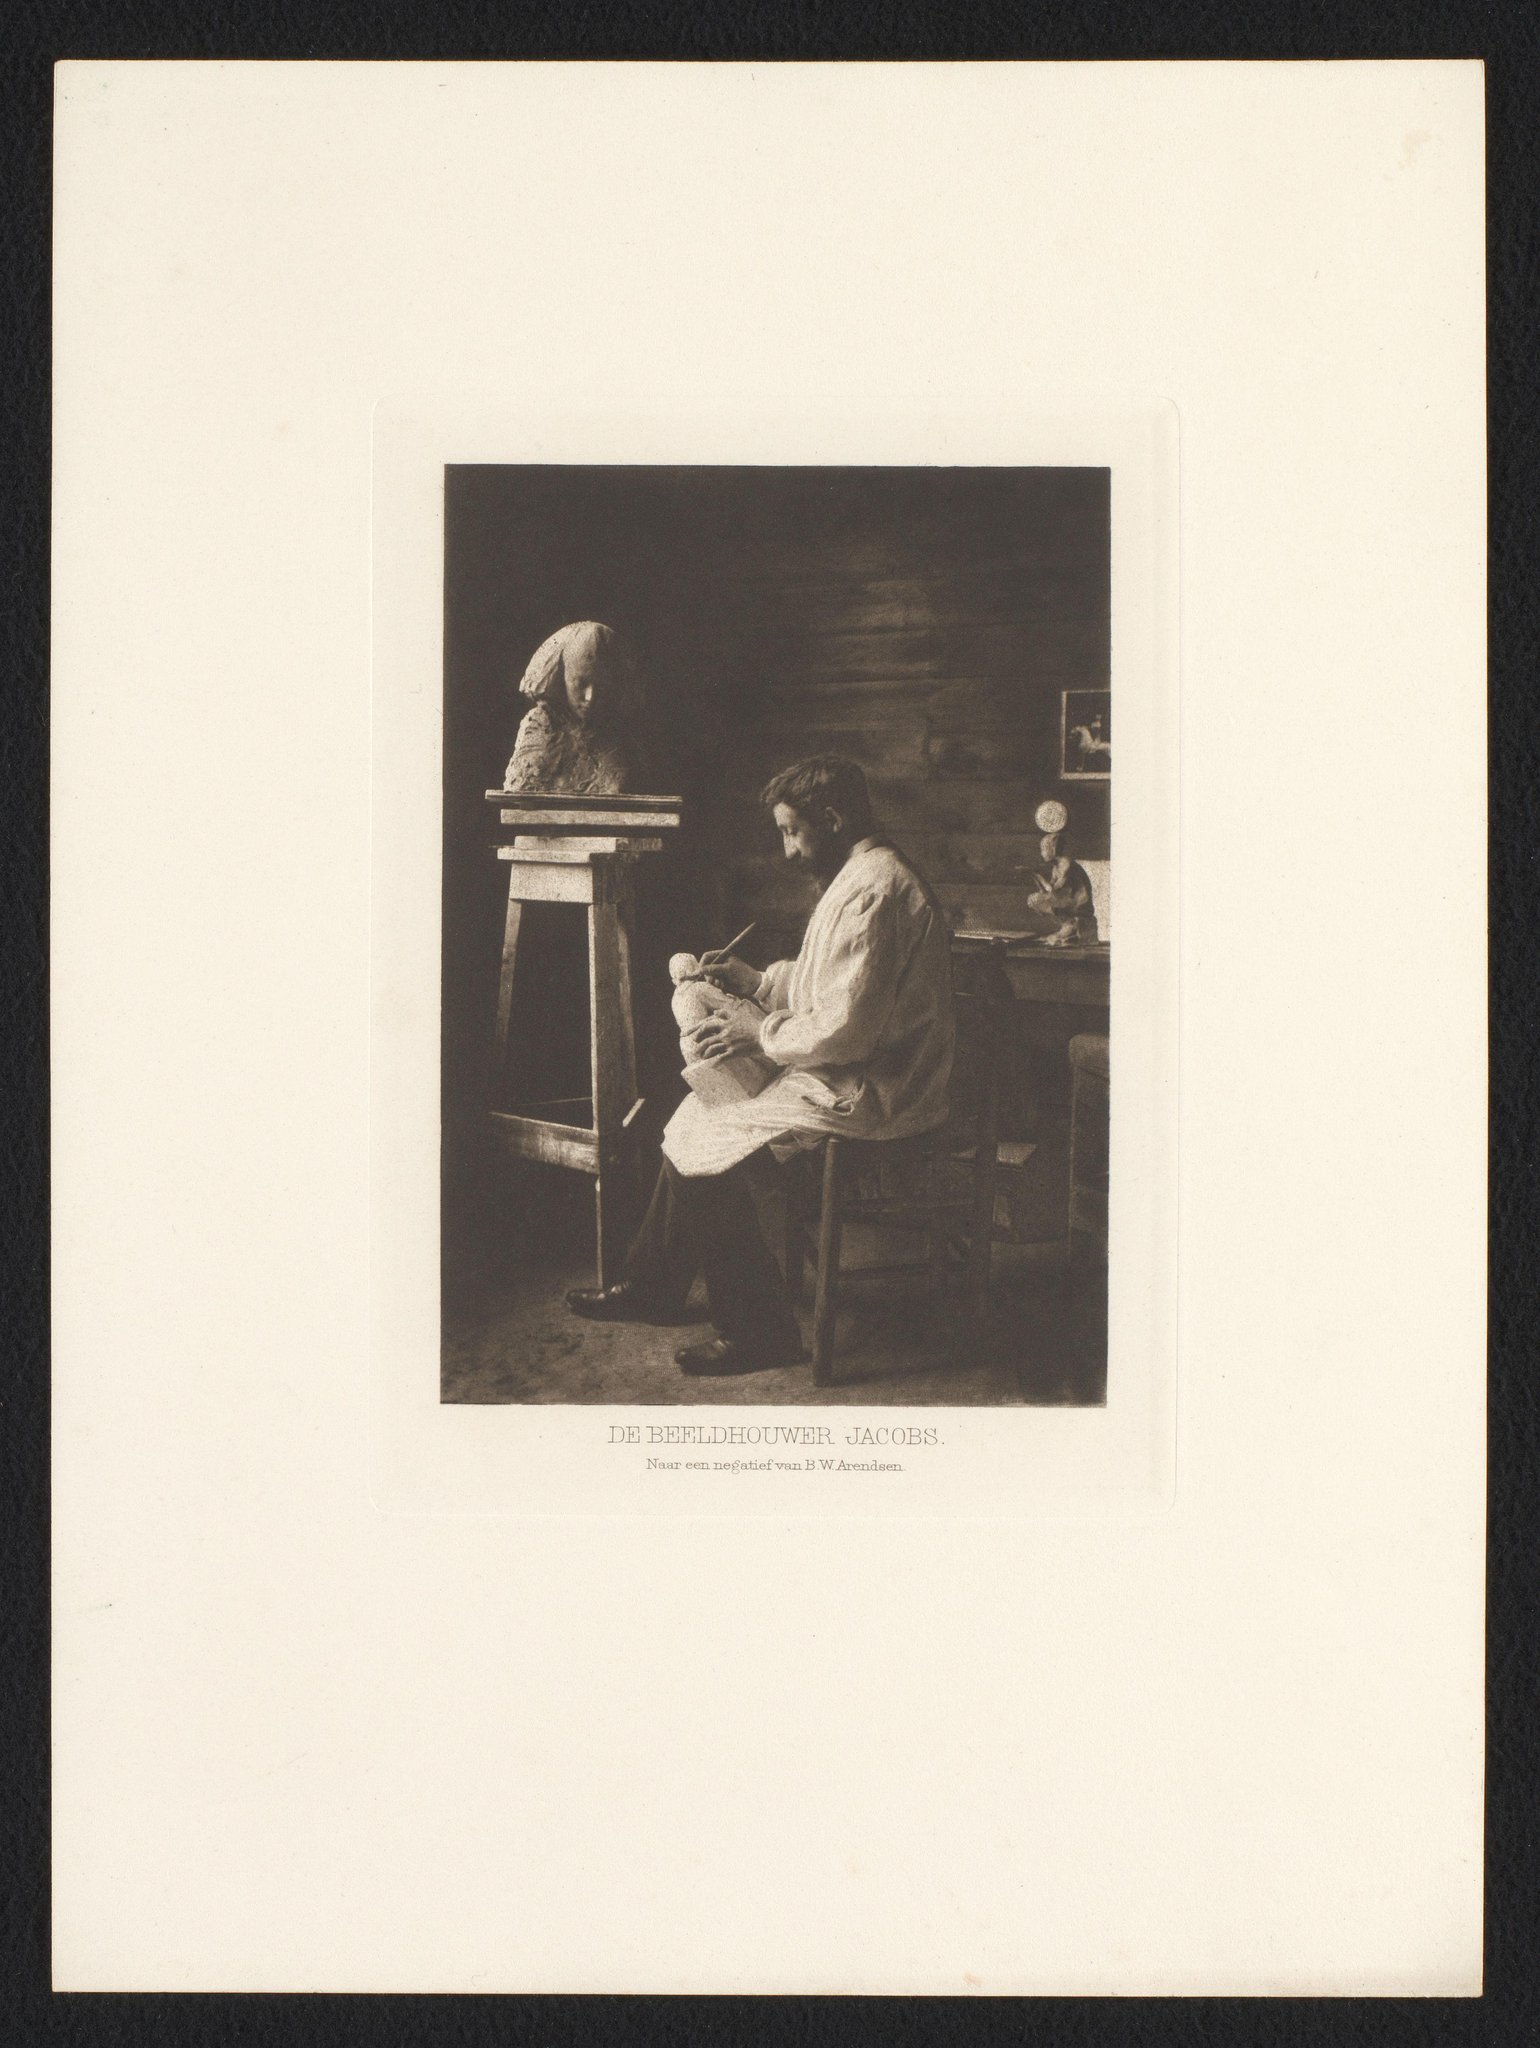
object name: page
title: De beeldhouwer Jacobs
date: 1899-1904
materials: paper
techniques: photoaquatint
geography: netherlands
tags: amsterdam, painter, sculptor, portrait, self-portrait of sculptor, workshop, studio of the artist (in general), historical persons (portraits and scenes from the life)